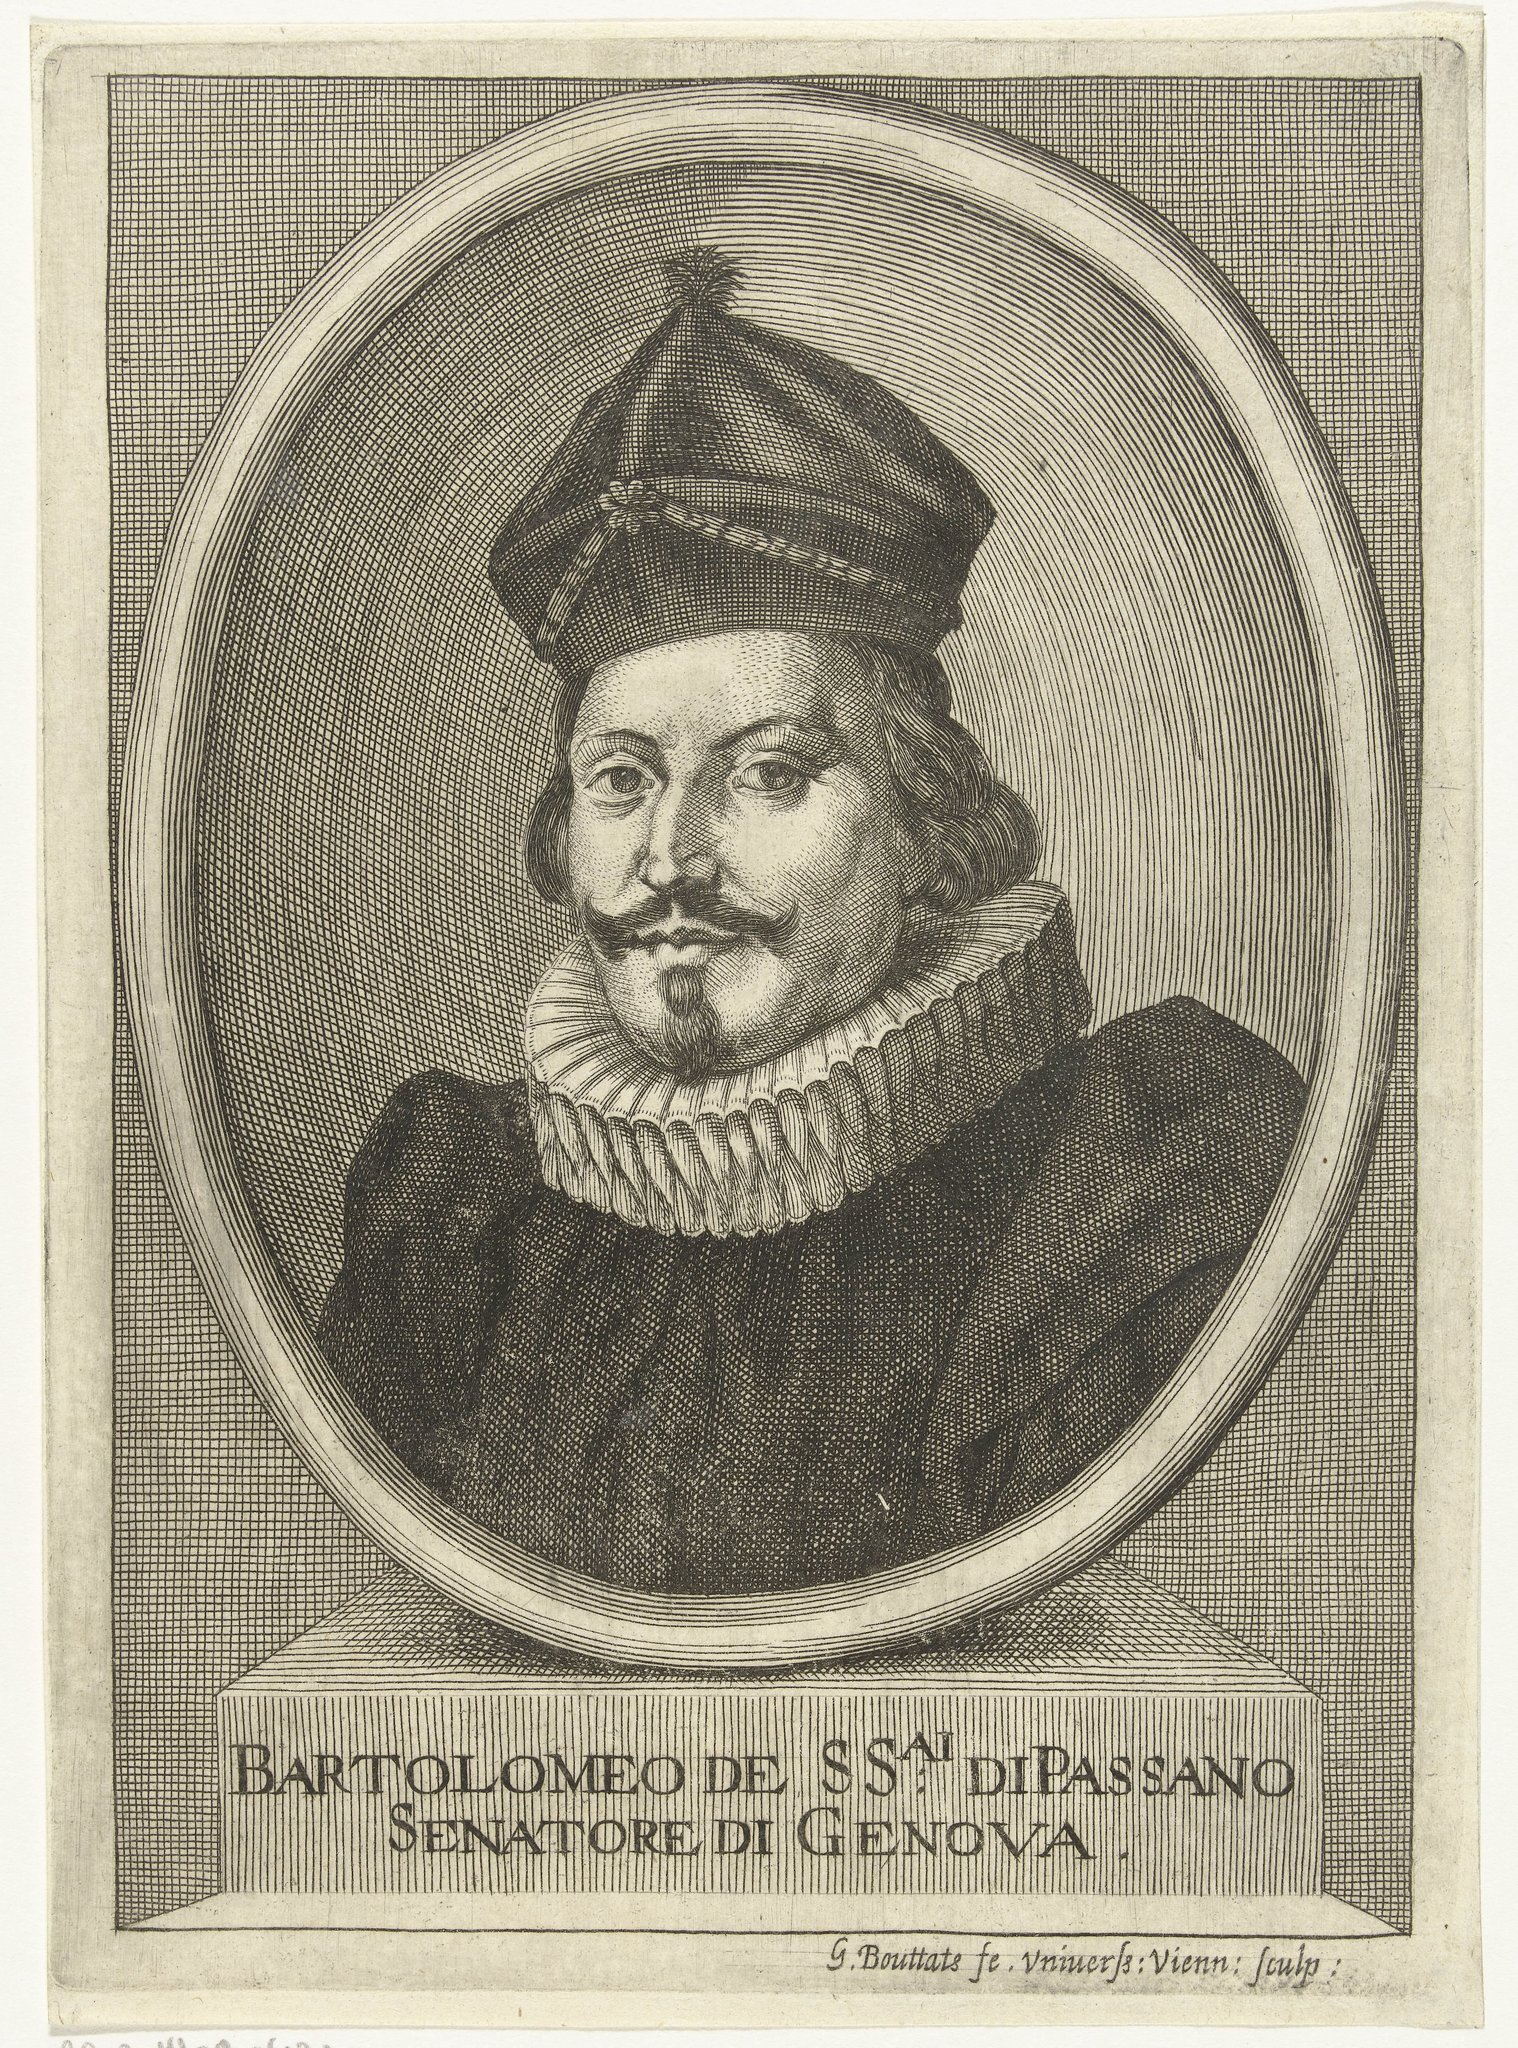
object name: print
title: Portret van Bartolomeo di Passano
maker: gerard bouttats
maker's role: print maker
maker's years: 1630-1668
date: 1655-1668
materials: paper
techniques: engraving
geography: vienna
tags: bartolomeo di passano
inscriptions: collector's mark: Lugt 2228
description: Portret in ovale lijst van Bartolomeo di Passano, een Genuaanse senator. Buste naar links. Passano draagt een biretta en een grote kraag. De prent heeft een Italiaans onderschrift.